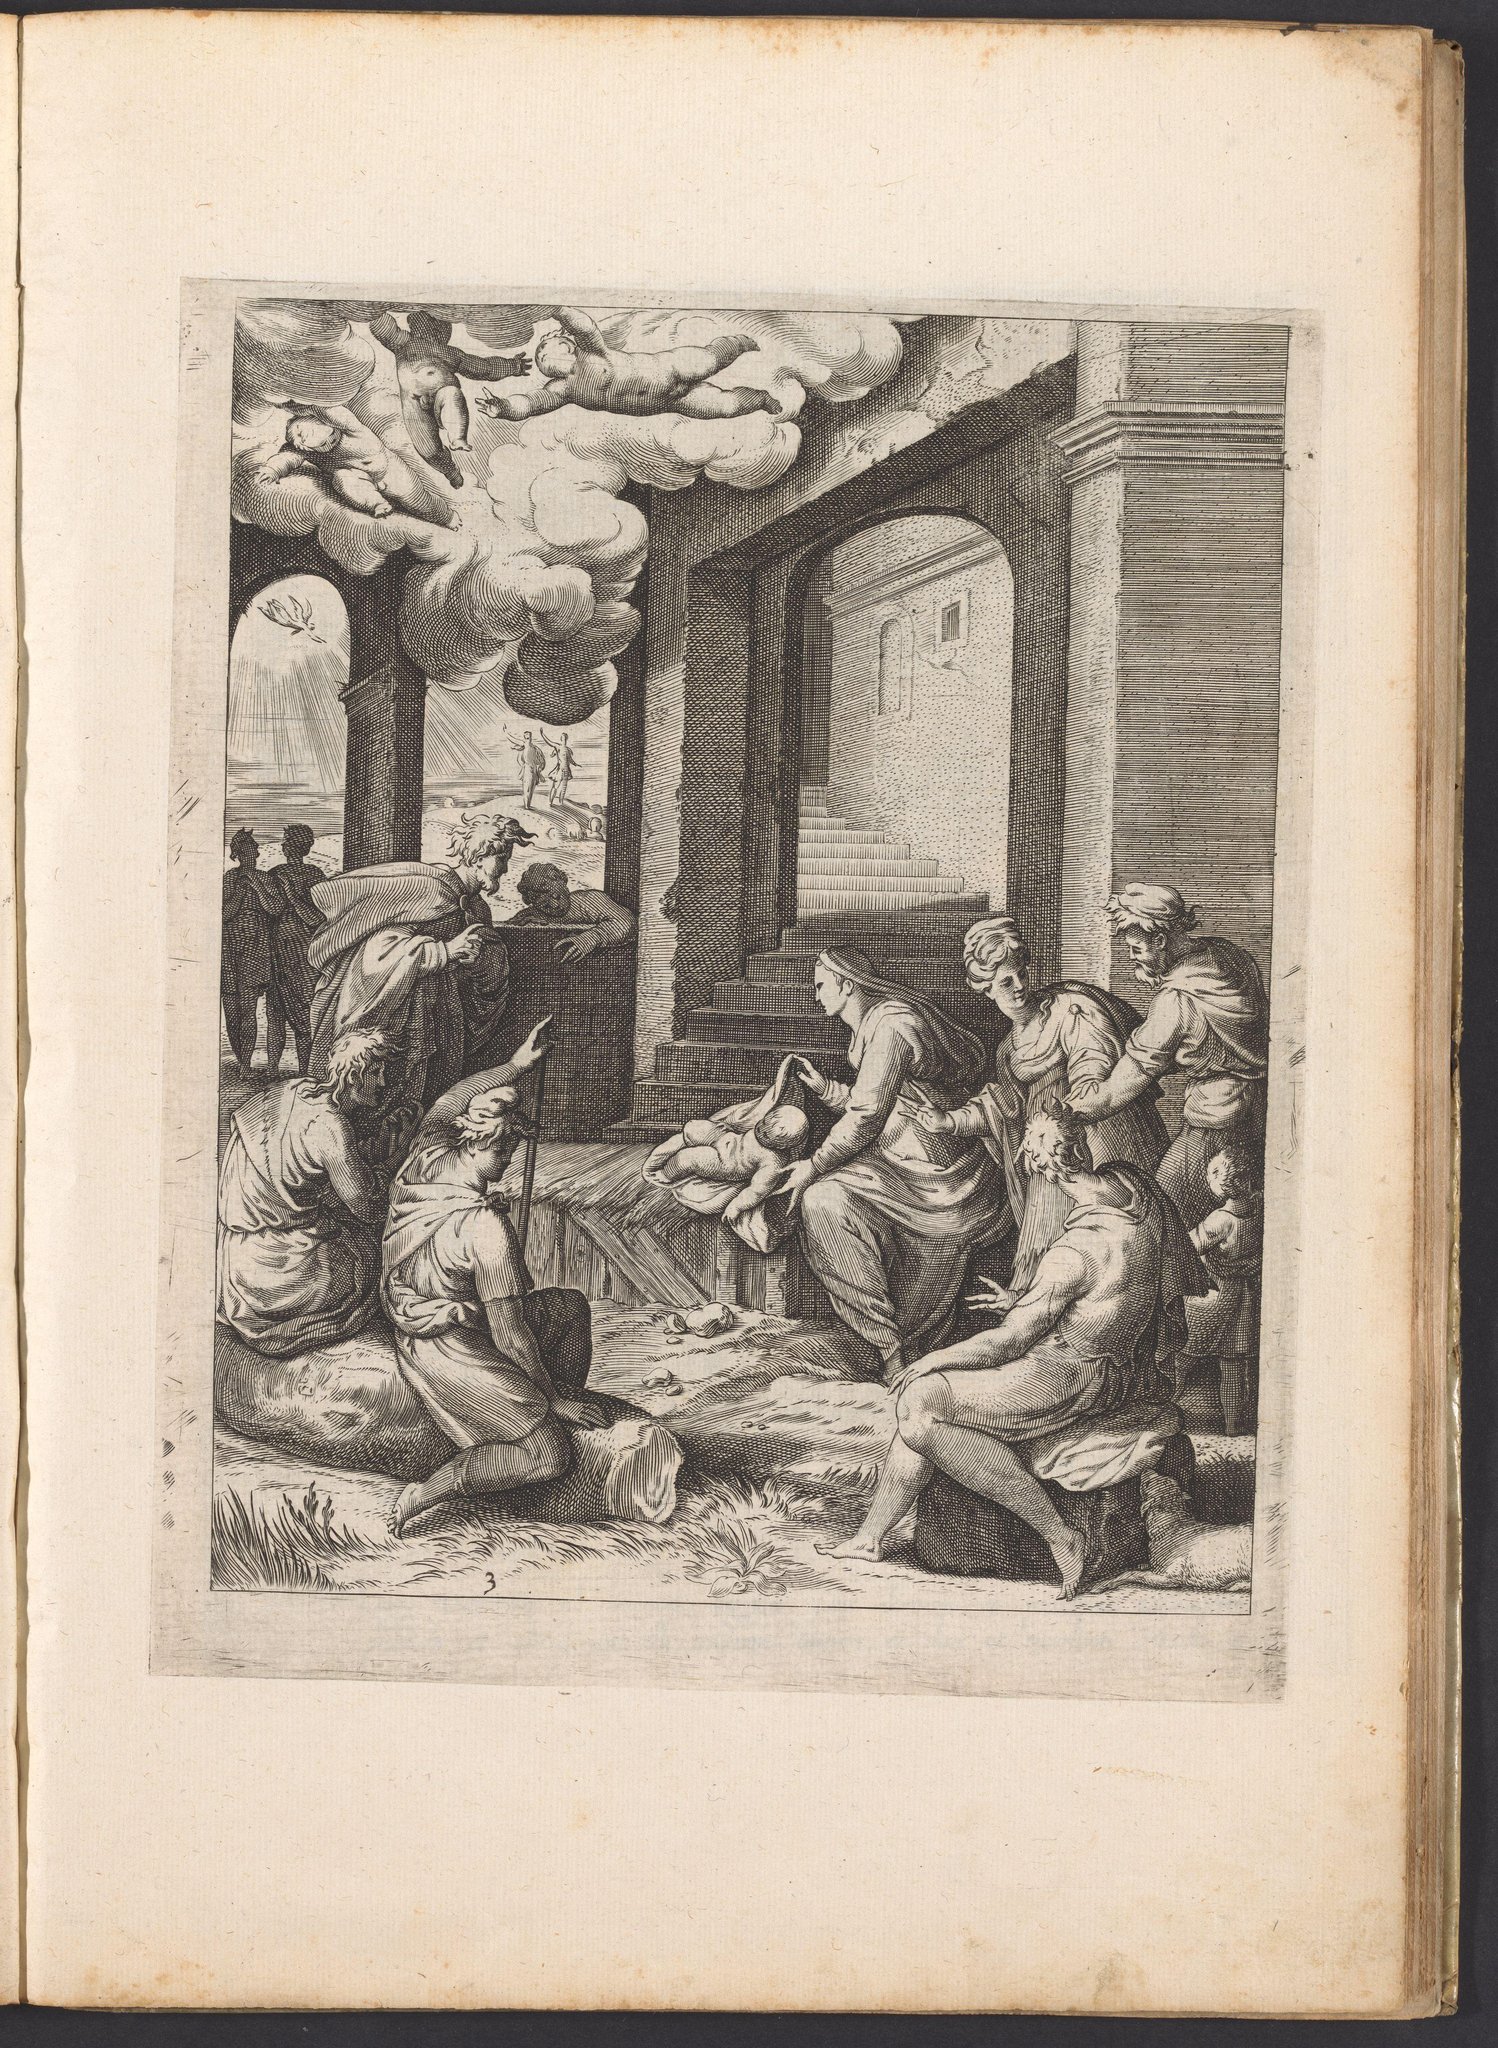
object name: print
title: Aanbidding door de herders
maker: isaac duchemin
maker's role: draughtsman, print maker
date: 1573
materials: paper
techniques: engraving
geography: brussels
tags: adoration of the christ-child by the shepherds; mary and joseph present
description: Deze prent maakt deel uit van een album.